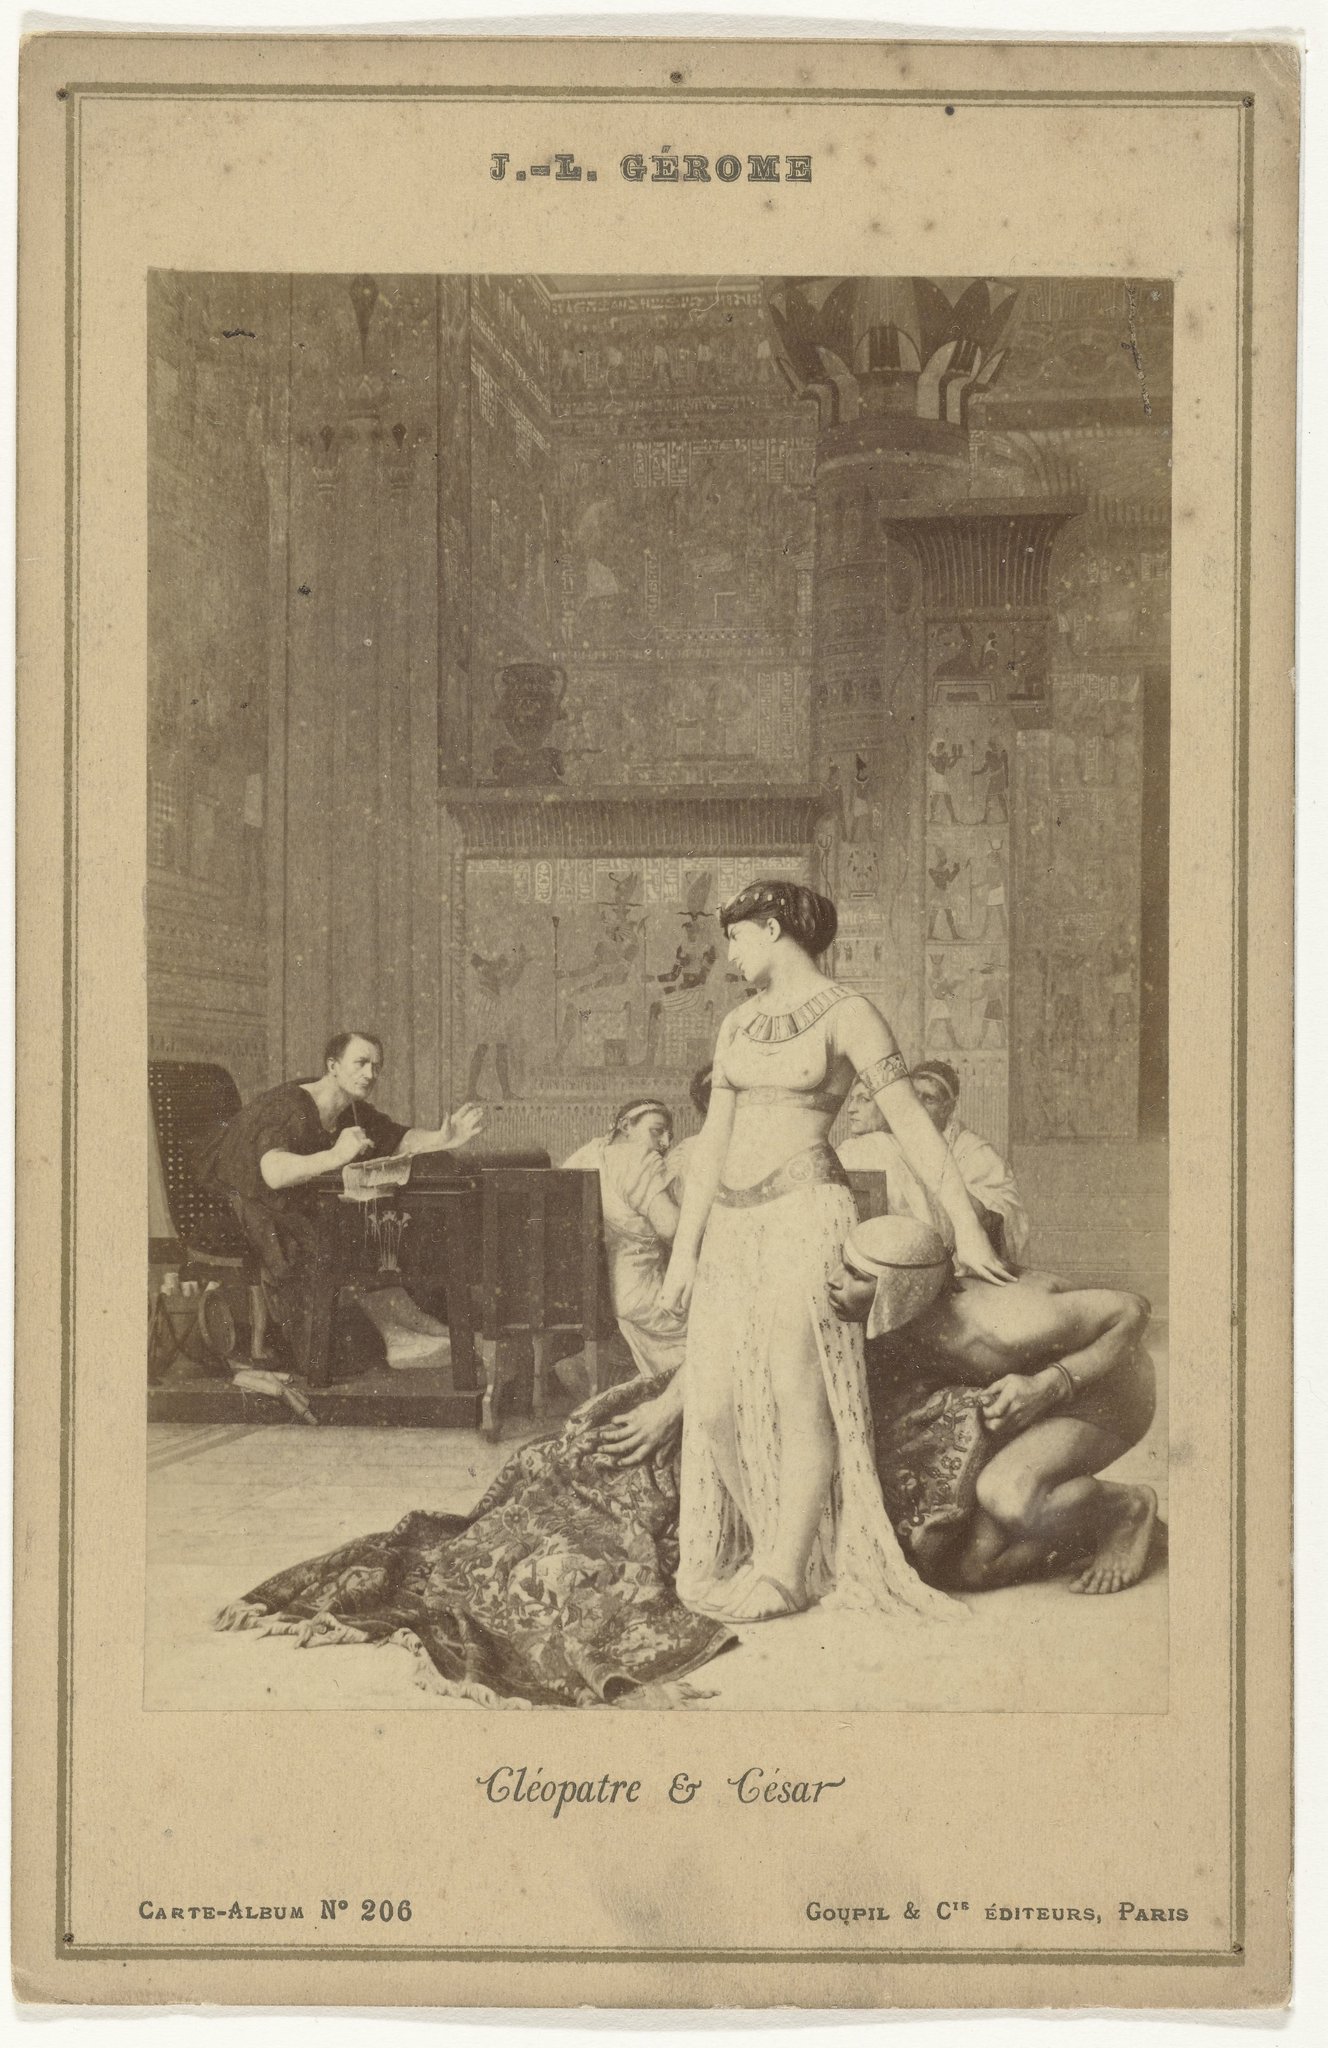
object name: photograph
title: Fotoreproductie van het schilderij Cléopatre & César door Jean-Léon Gérôme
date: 1870-1884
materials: cardboard, paper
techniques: albumen print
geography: paris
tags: (story of) cleopatra, (story of) c. julius caesar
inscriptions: inscription: ‘Carte-Album No 206/ Goupil & Cie Éditeurs, Paris’, inscription: ‘J.L. Gérome/ Cléopatre & César’, stamp: ‘Akademische boekhandel/ van de firma/ Jacq Hazenberg Cornez./ Rapenburg Leiden’, check stamp: ‘Goupil & Cie’, collector's mark: ‘Vosmaer’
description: Het schilderij toont Cleopatra die het paleis is binnengesmokkeld in een tapijt en zich voor de ogen van Caesar presenteert.